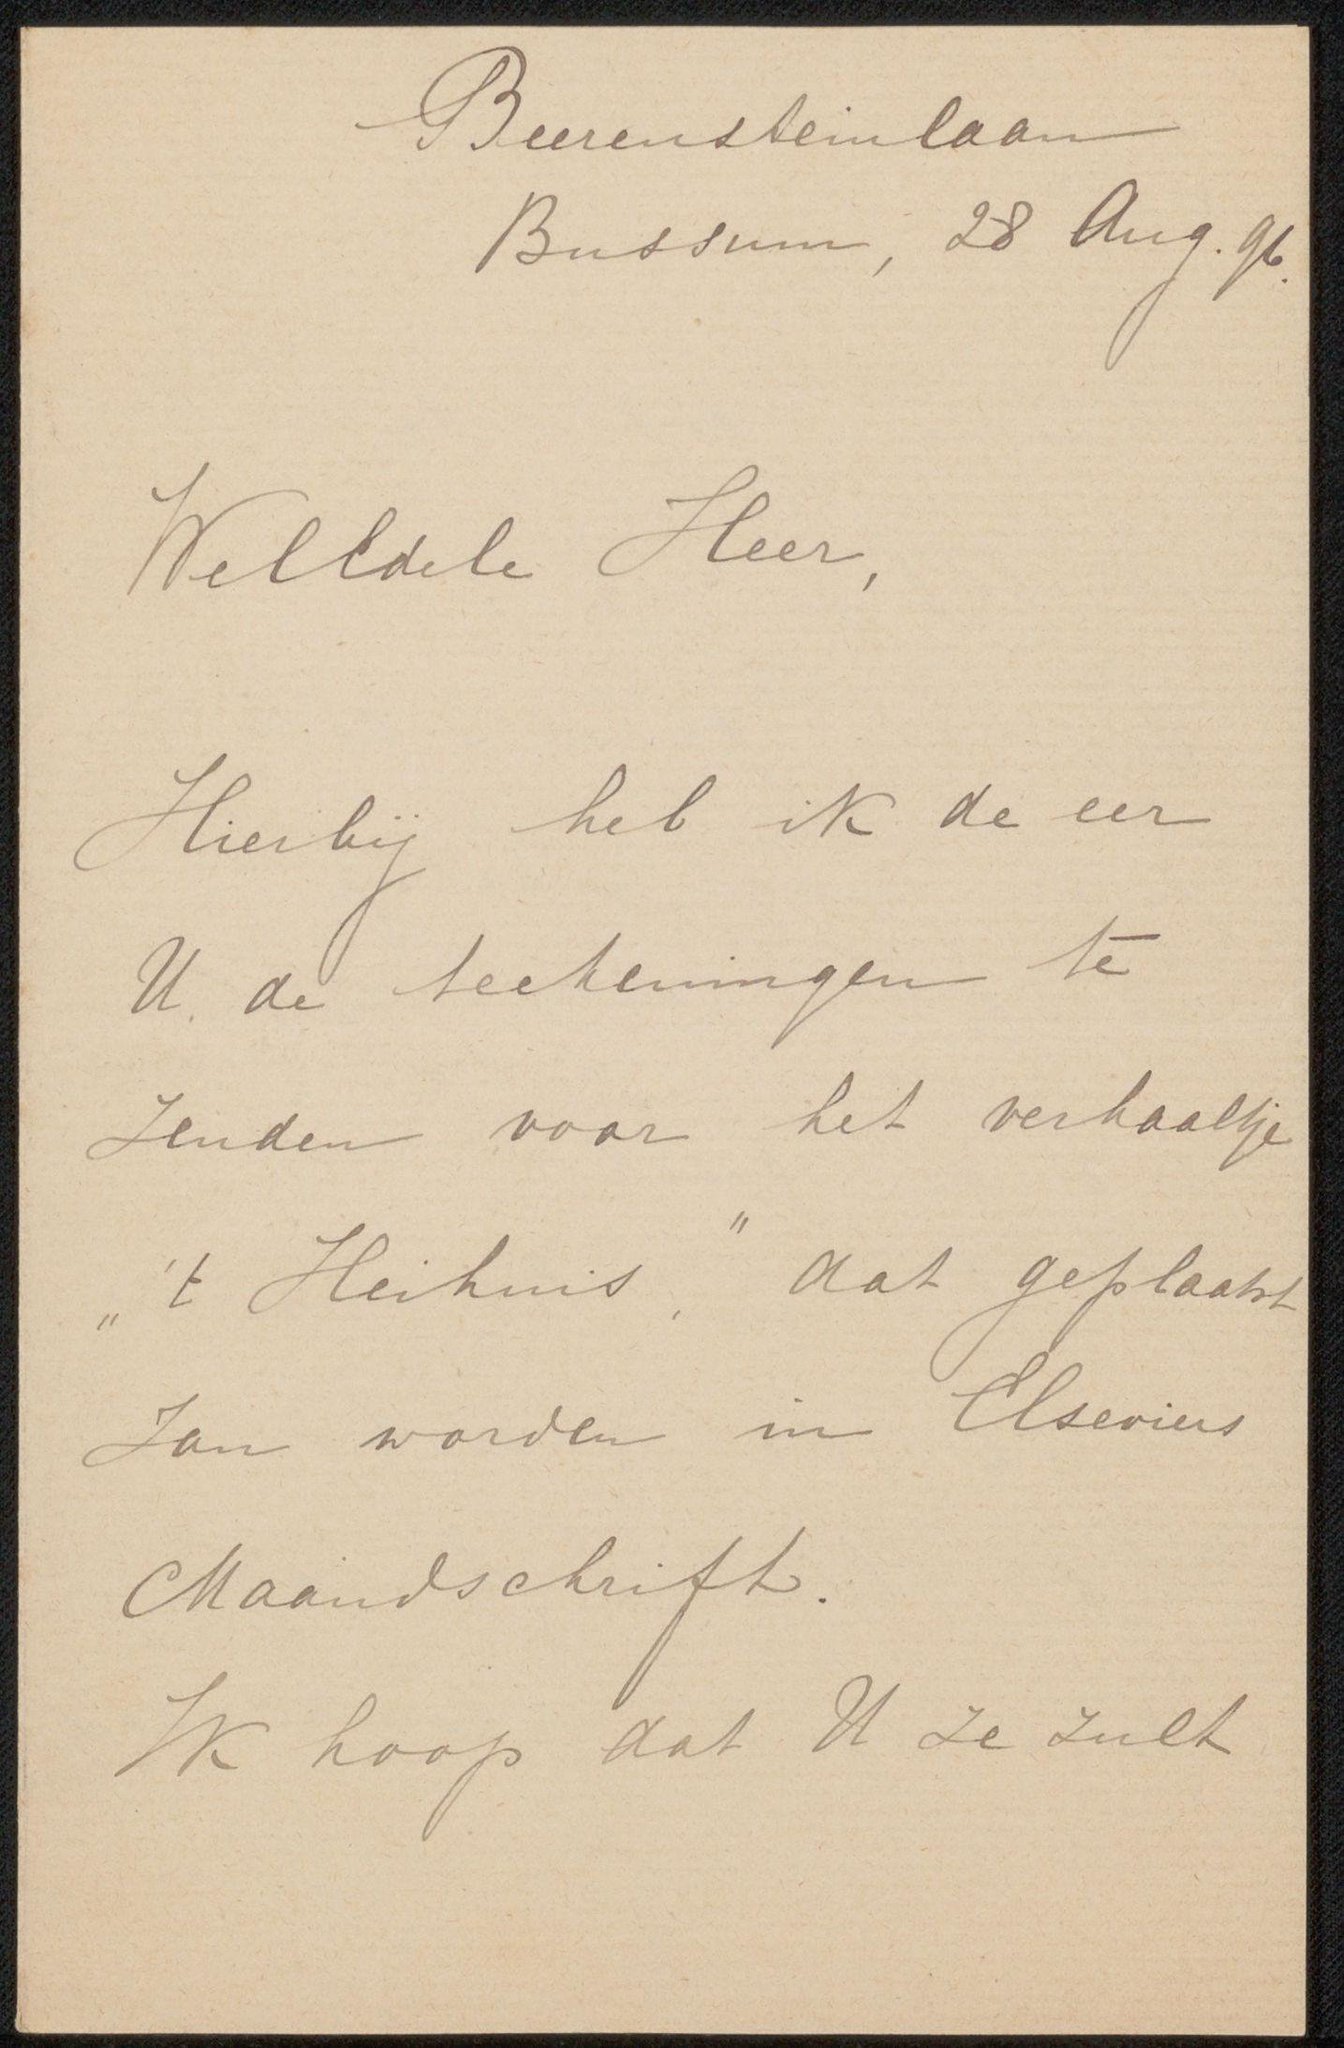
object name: letter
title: Brief aan Philip Zilcken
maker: henriëtte de vries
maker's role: draughtsman, print maker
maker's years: 1867-1942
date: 1896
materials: ink, paper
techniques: pen, writing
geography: bussum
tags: the hague, painter, philip zilcken, drawing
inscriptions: collector's mark: ‘RPK’